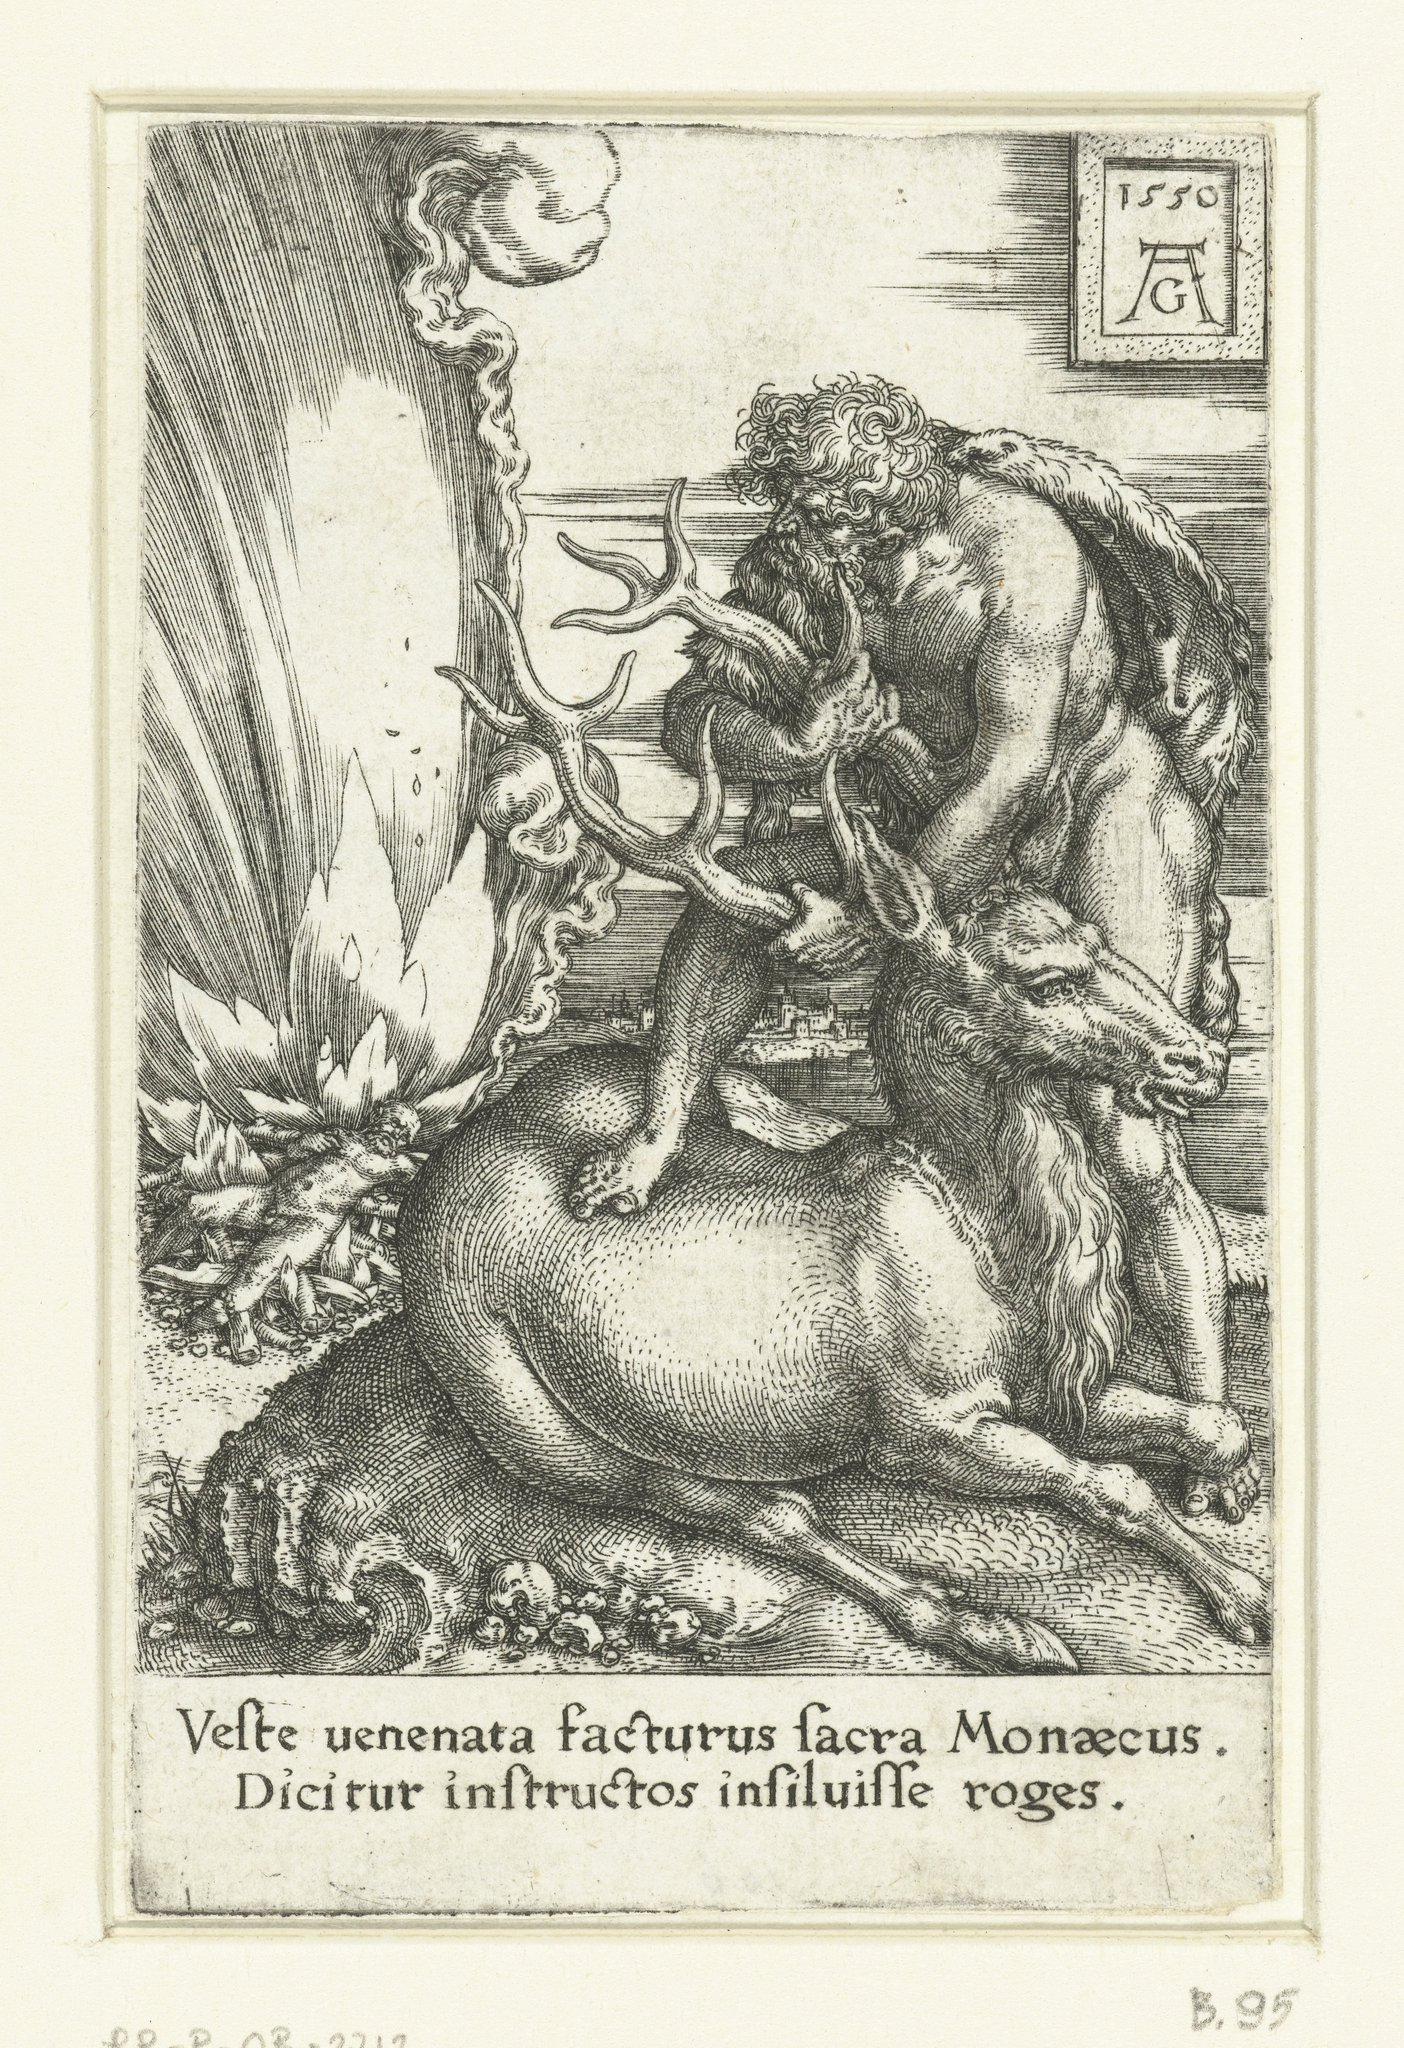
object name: print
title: Werken van Hercules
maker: heinrich aldegrever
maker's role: draughtsman, print maker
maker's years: 1502-1561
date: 1550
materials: paper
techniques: engraving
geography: germany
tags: death of hercules, (3) the ceryneian hind of arcadia is captured by hercules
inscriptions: number: ‘106’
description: Hercules, staand achter het hert, houdt met beide handen het gewei vast, terwijl hij met een been het dier op de grond duwt. Daarachter is Hercules te zien na zijn dood, liggend op de brandende brandstapel. Onder de voorstelling een tweeregeleige tekst in het Latijn. Dertiende prent van dertien met de werken van Hercules.